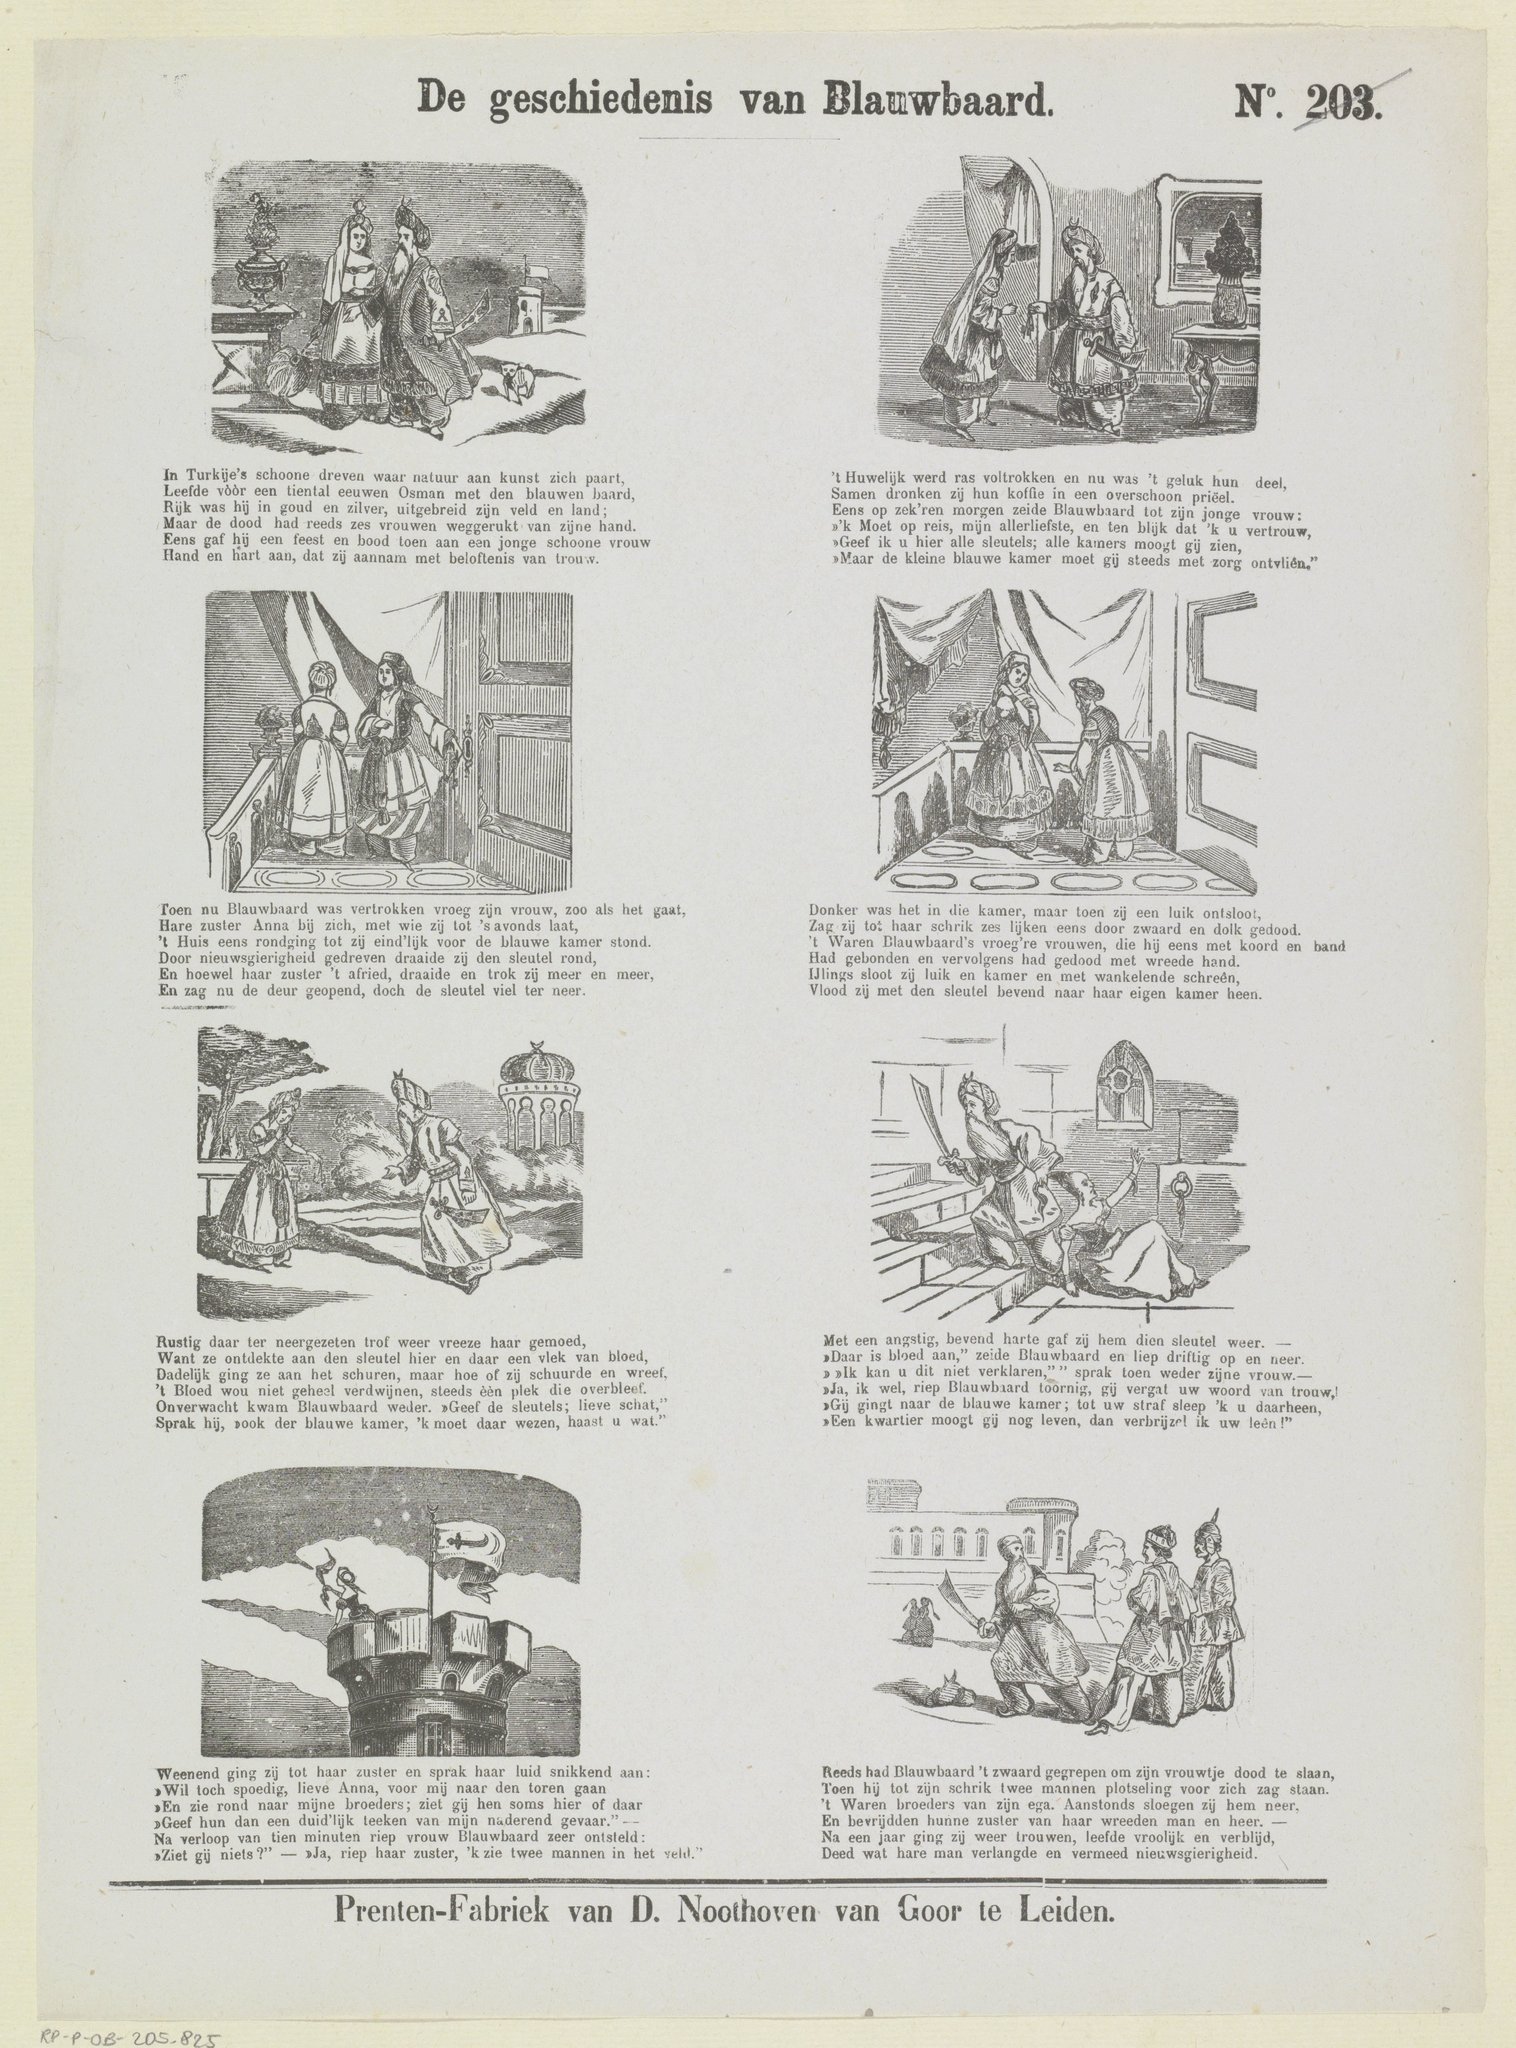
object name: print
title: De geschiedenis van Blauwbaard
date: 1850-1881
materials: paper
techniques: letterpress printing, engraving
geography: leiden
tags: tales and fairy tales (with title)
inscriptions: collector's mark: Lugt 2760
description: Blad met 8 voorstellingen uit het sprookje van Blauwbaard. Onder elke voorstelling een zesregelig vers. Genummerd rechtsboven: No. 203.